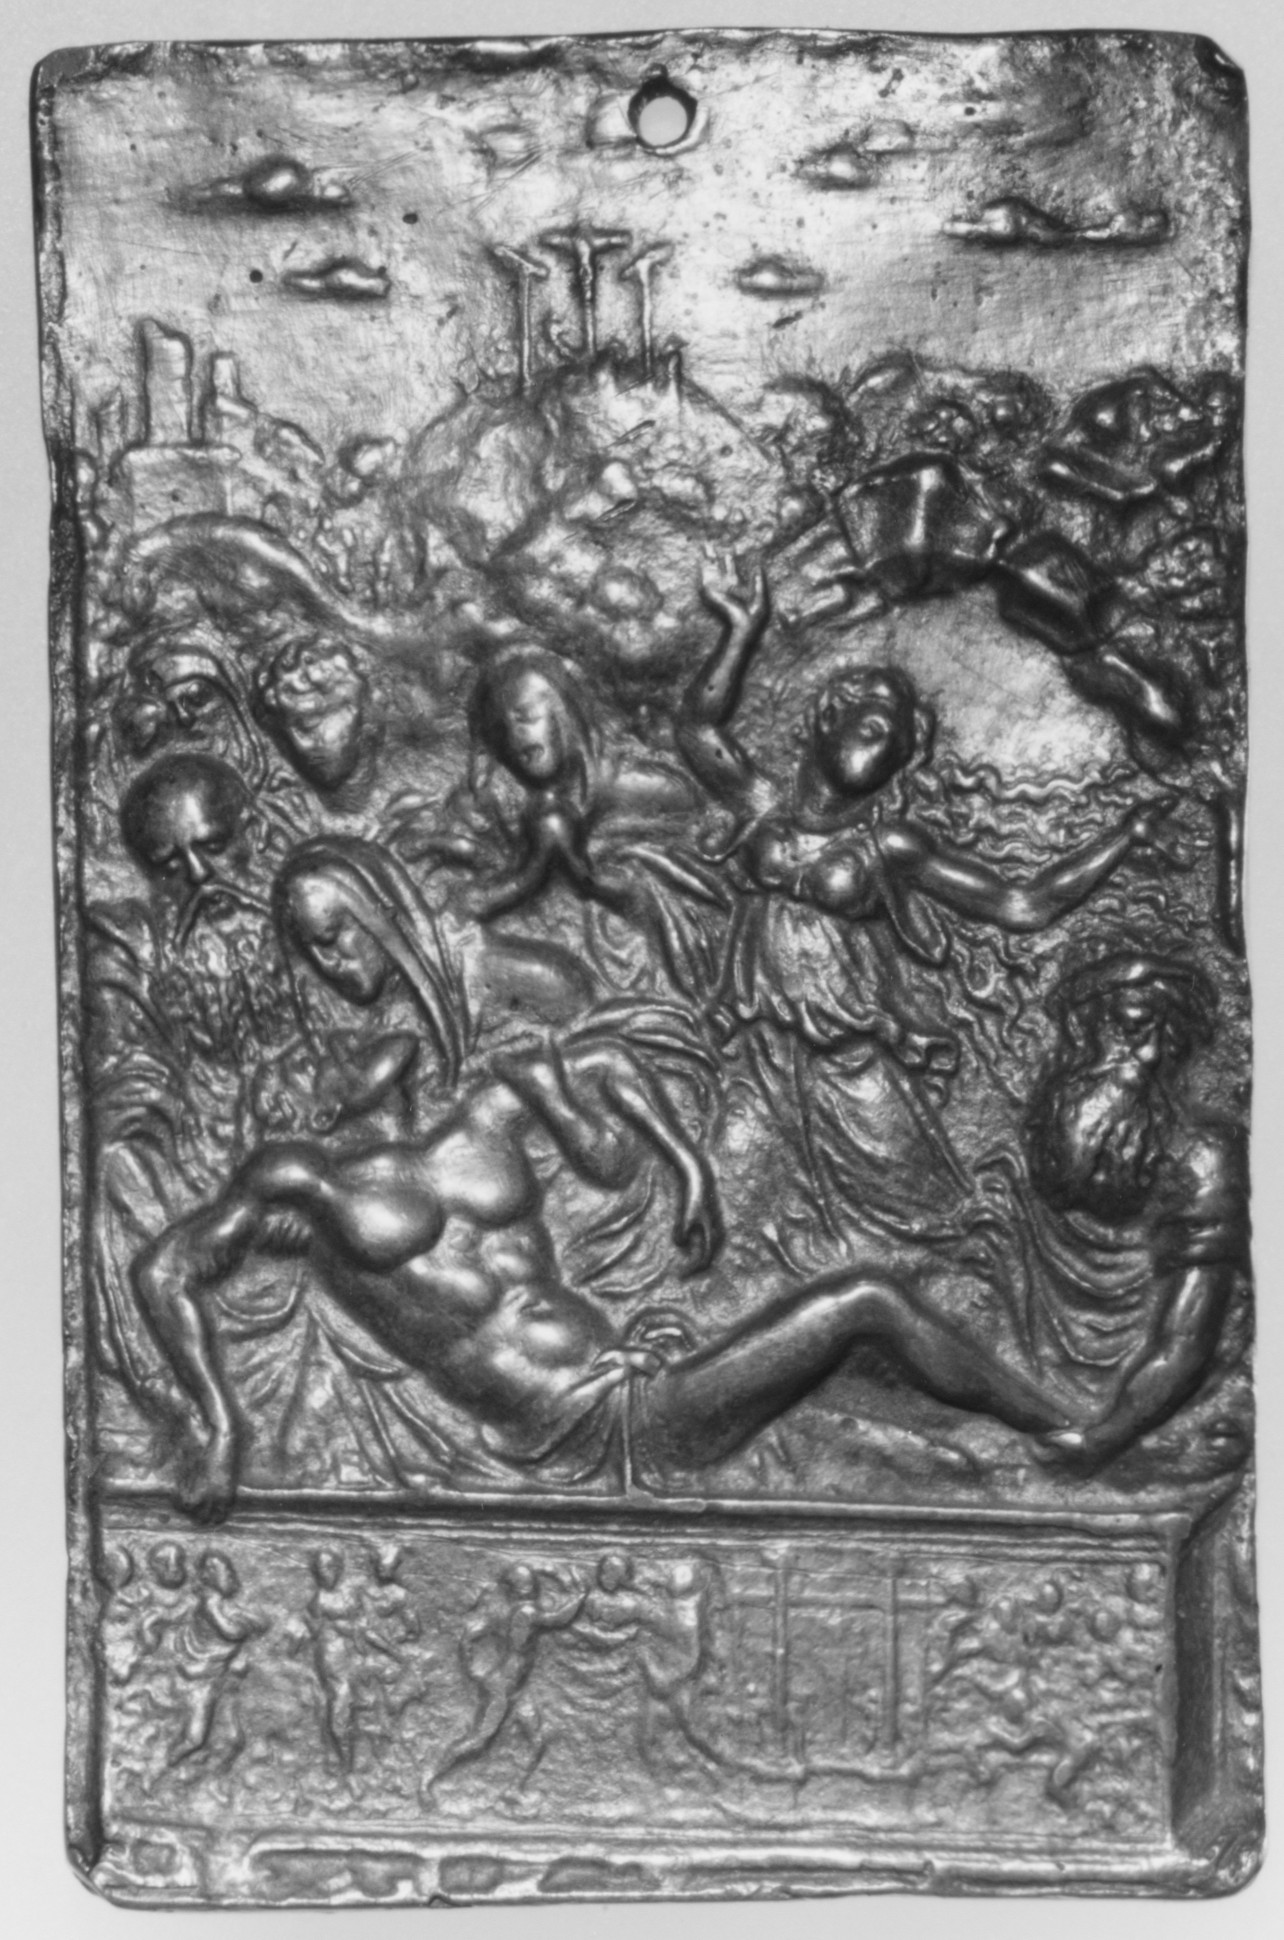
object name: plaquette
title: The Entombment of Christ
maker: moderno (galeazzo mondella)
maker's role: maker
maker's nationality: italian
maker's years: 1467-1528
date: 1501-1600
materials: bronze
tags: christ,entombment